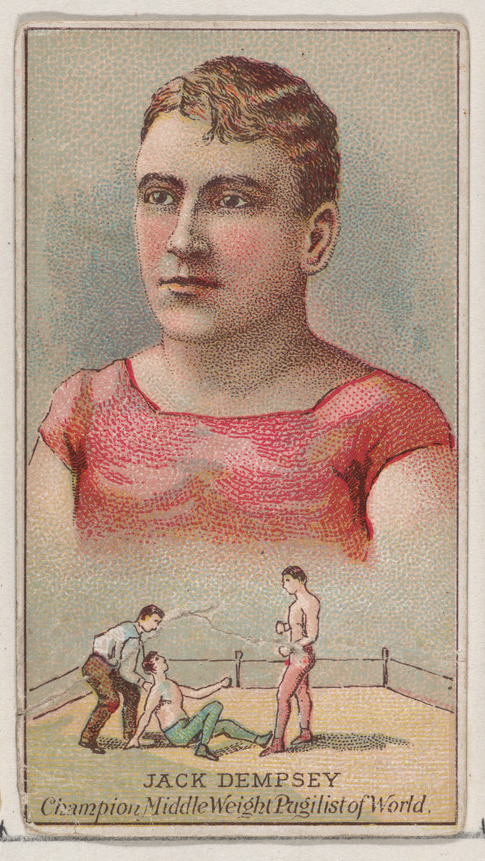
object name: print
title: Jack Dempsey, Champion Middle Weight Pugilist, from the Champions of Games and Sports series (N184, Type 2) issued by W.S. Kimball & Co.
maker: w.s. kimball & co.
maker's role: publisher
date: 1887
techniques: color lithograph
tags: men,boxing,athletes